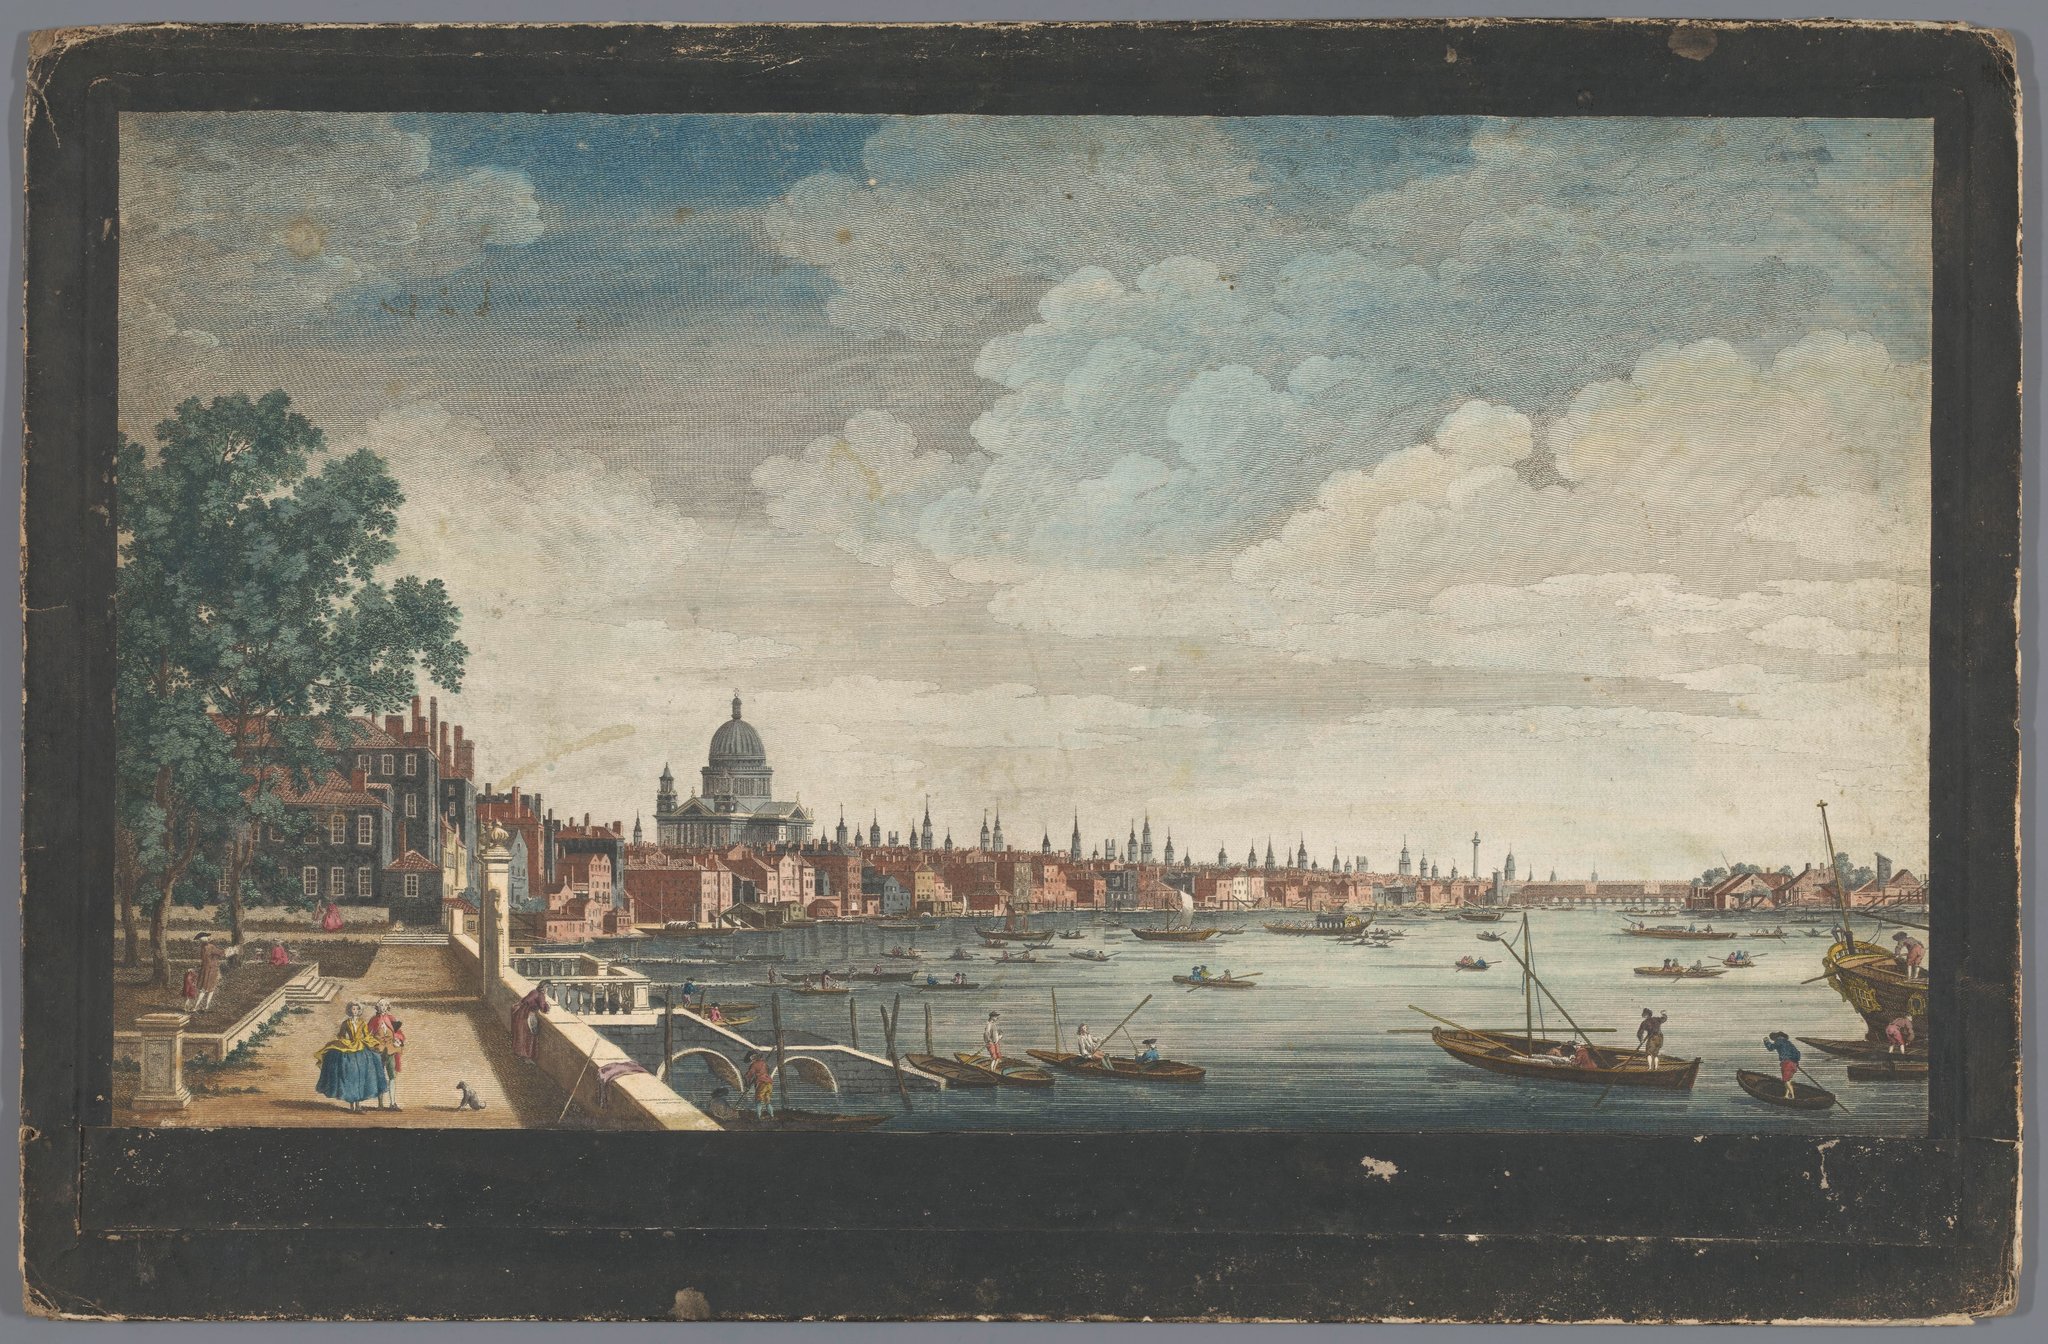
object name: print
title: Gezicht op de London Bridge over de rivier de Theems te Londen, gezien vanaf de tuin van Somerset House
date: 1750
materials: cardboard, paper, watercolor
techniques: brush, etching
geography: london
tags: bridge in city across river, canal, etc. (+ city(-scape) with figures, staffage), sailing-ship, sailing-boat, garden, church (exterior), rowing-boat, canoe, etc., thames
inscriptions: collector's mark: Lugt 2233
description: De serie “Londen” bevat 52 prenten met de nummers 1-52, waarvan dit nummer 5 is.